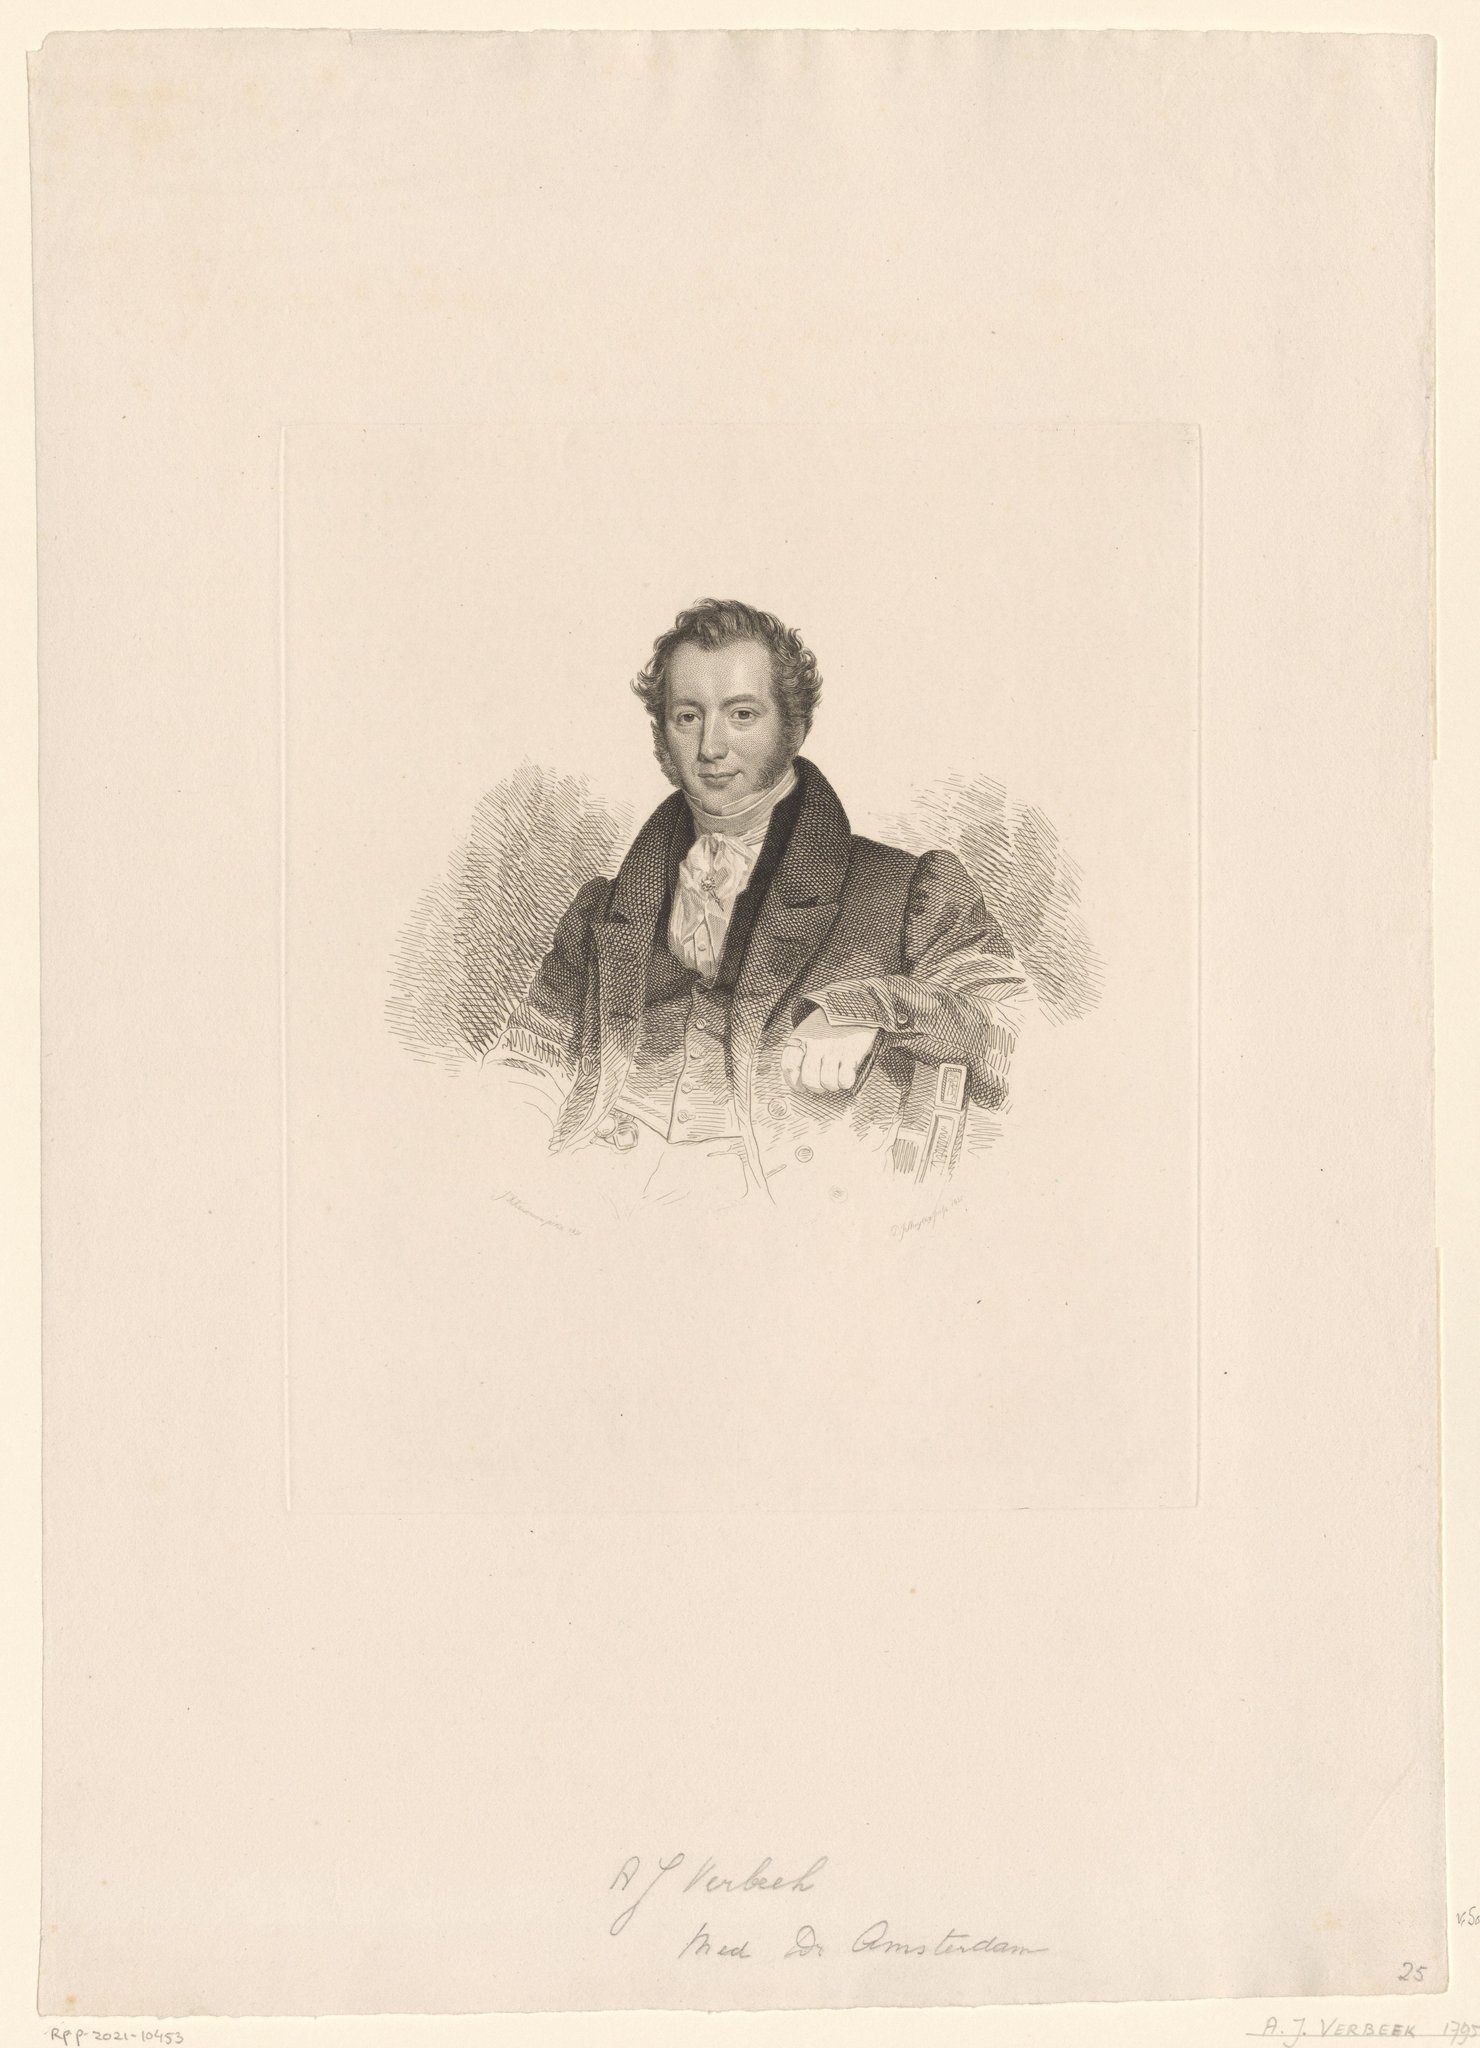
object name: print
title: Portret van Albert Jan Verbeek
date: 1835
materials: paper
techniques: engraving, etching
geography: amsterdam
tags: dordrecht, historical persons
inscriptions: collector's mark: Lugt 2228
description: Vervaardigd naar een geschilderd portret van Jan Adam Kruseman uit 1831.